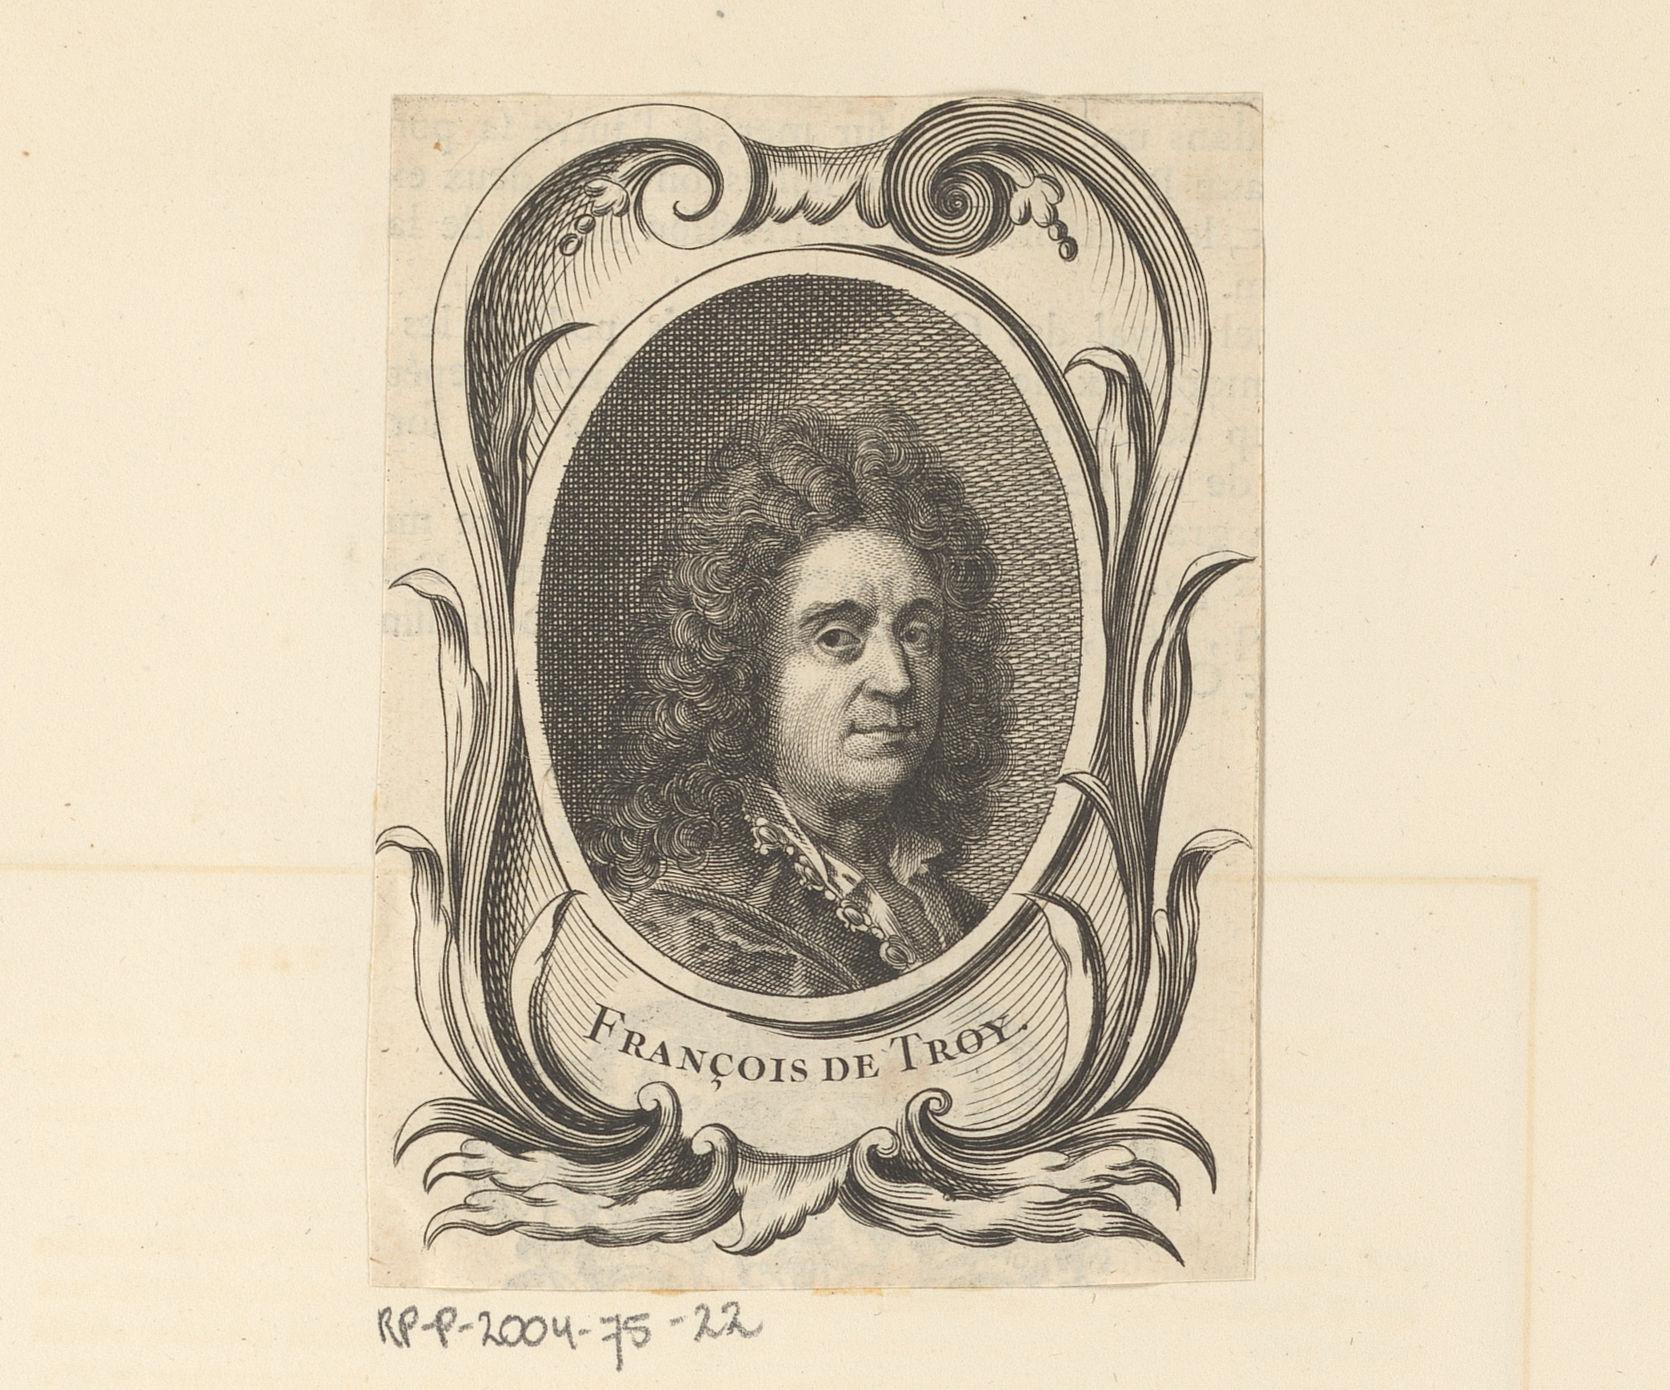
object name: album leaf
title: François de Troy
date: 1745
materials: paper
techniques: engraving, letterpress printing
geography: paris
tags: paris, painter, françois de troy, historical persons, portrait, self-portrait of painter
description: Prent uit: Dézallier d'Argenville, Antoine Joseph. Abrégé de la vie des plus fameux peintres. 4 dln. Parijs: De Bure l'aîné, 1745, dl. 2, p. 358. De samensteller heeft deze prent in het album geplakt als illustratie bij: Pilkington, Matthew en Johann Heinrich Füssli. A dictionary of painters, from the revival of the art to the present period. 4 dln. Londen: John Crowder, 1805, dl. 4, p. 569.